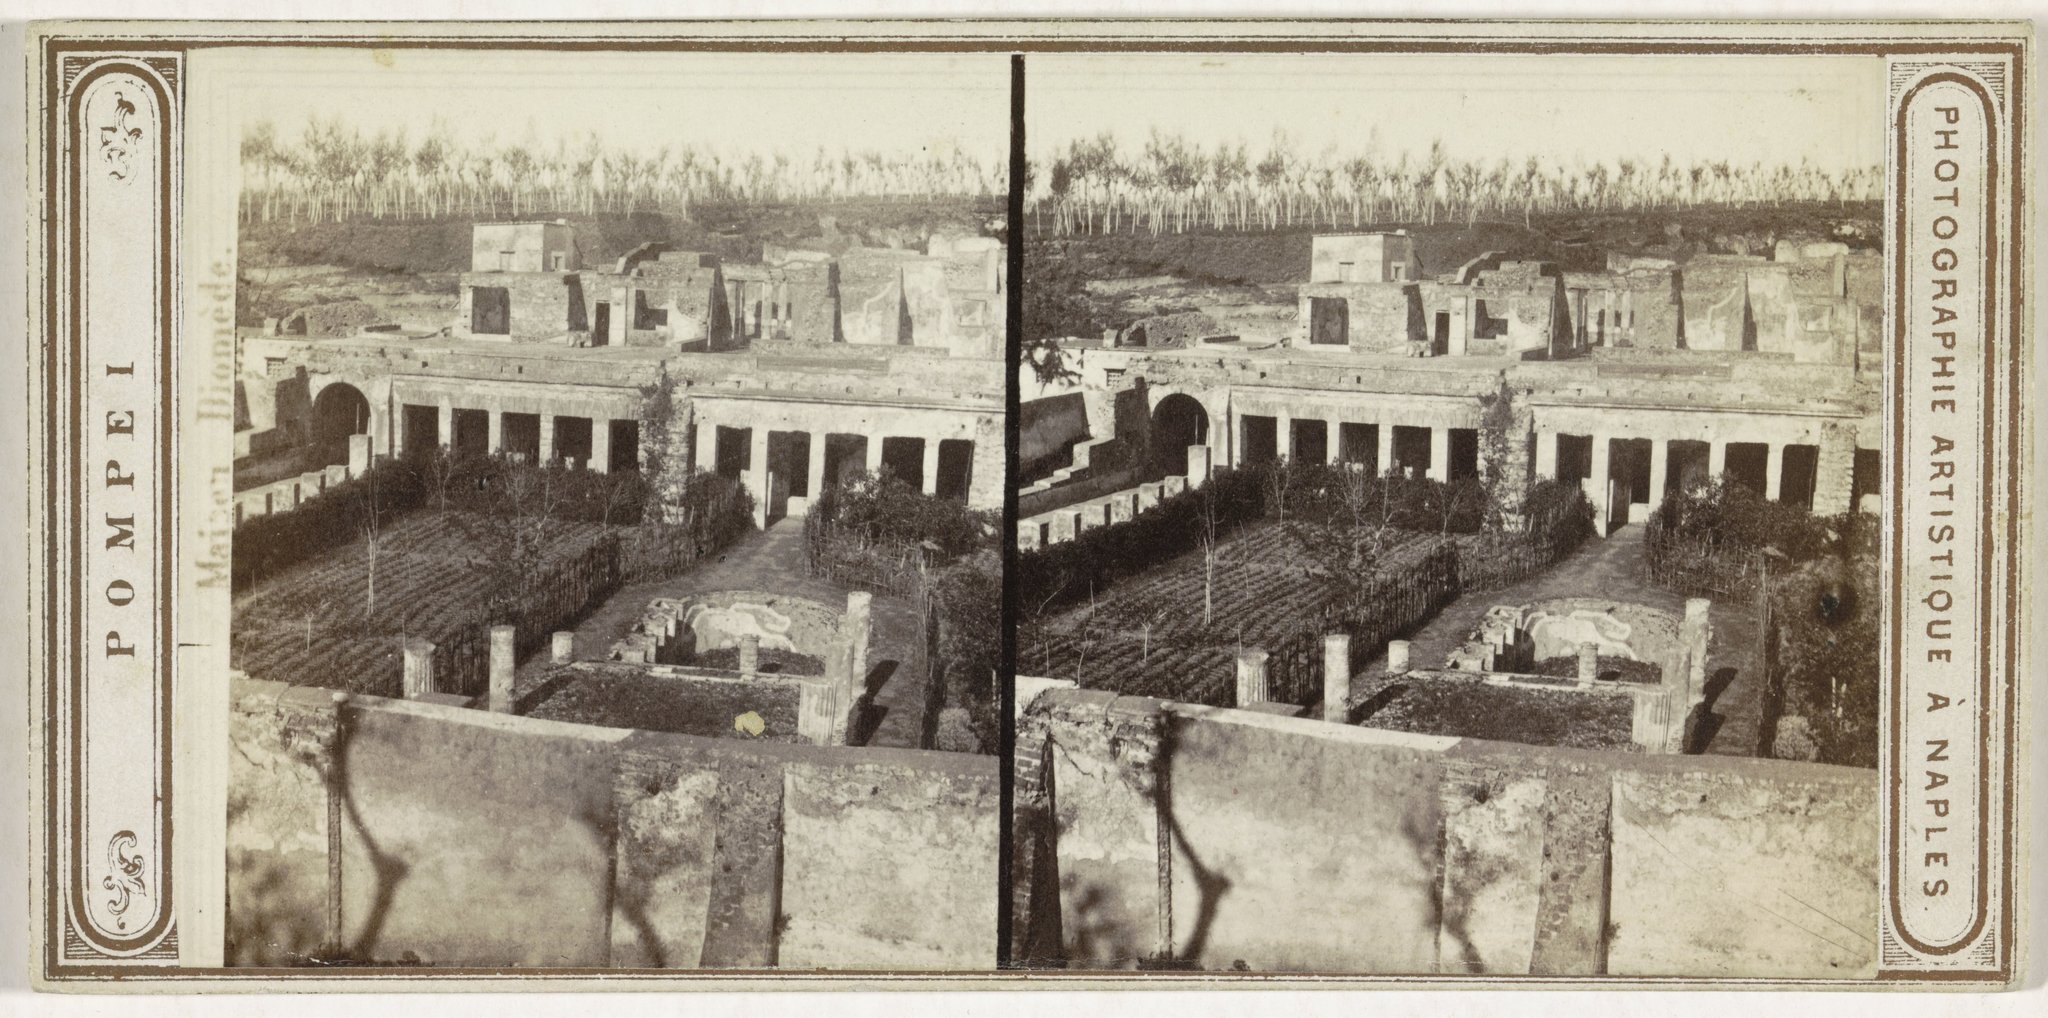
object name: stereograph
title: Casa di Diomède te Pompeï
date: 1865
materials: cardboard, paper, photographic support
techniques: albumen print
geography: naples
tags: pompeii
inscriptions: inscription: ‘15 €’, annotation: ‘Photographie à l'albumine circa 1865.’